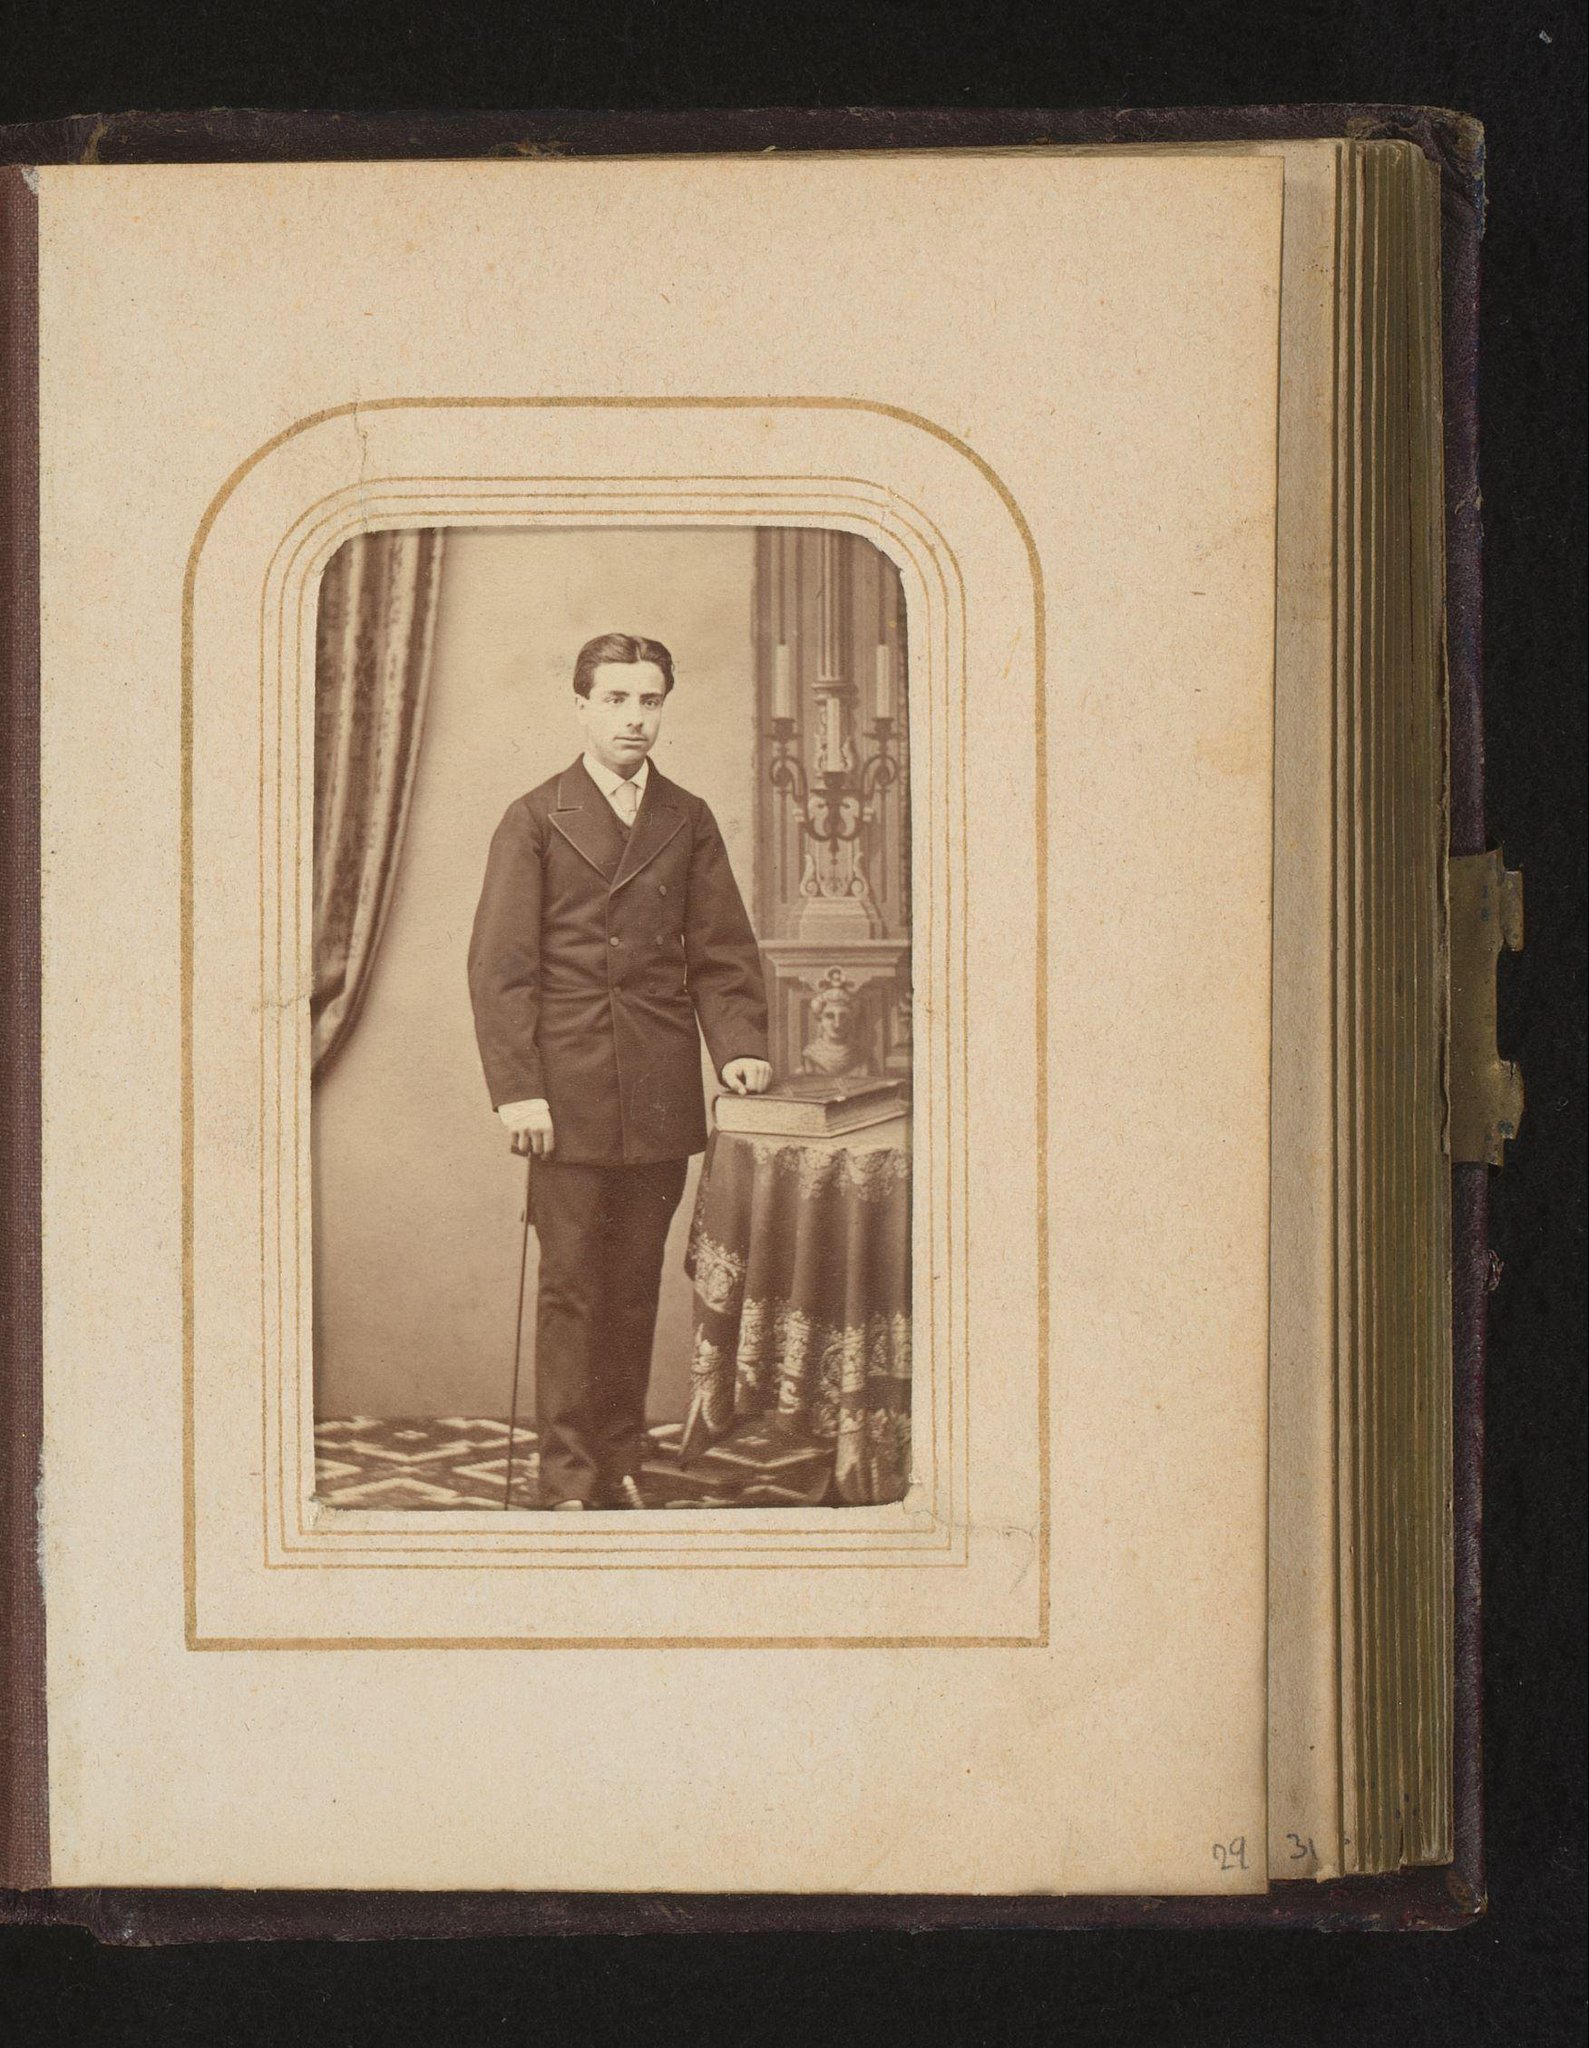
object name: carte de visite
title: Portret van een staande man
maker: juan hortelano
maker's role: fotograaf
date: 1860-1900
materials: cardboard, photographic support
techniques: albumen print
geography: valladolid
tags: historical persons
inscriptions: inscription: ‘Hortelano, Foto/ Valladolid’